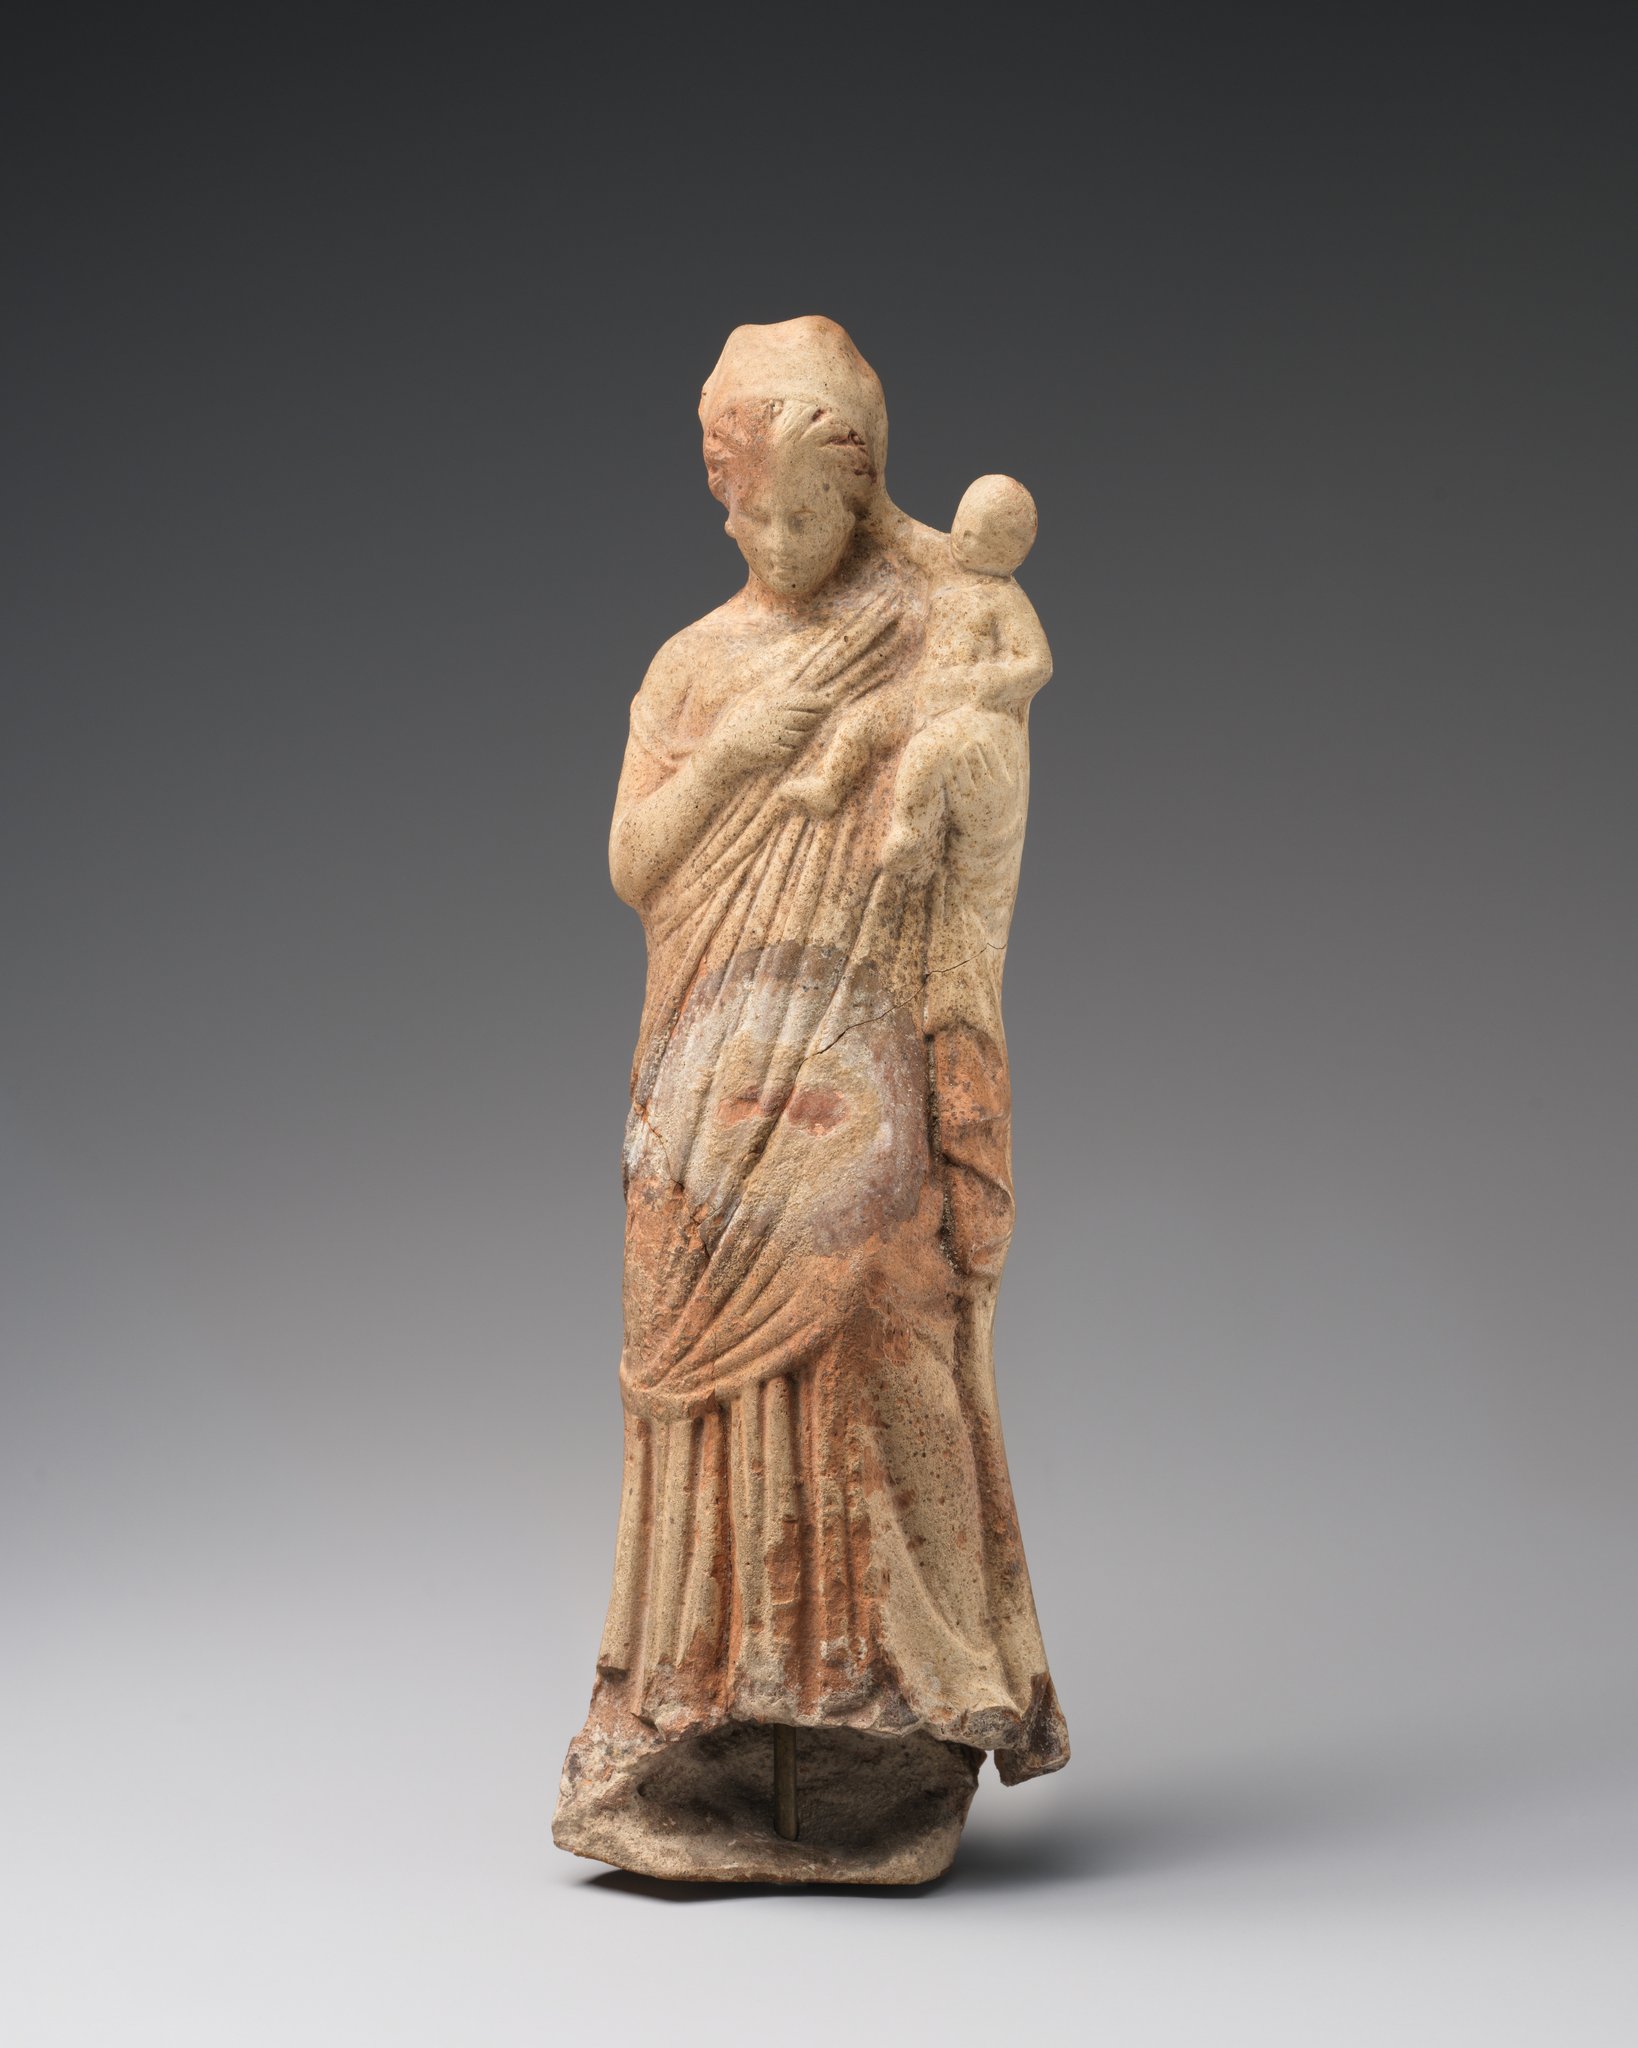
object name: statuette of a woman with infant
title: Terracotta statuette of a woman holding a baby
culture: greek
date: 200-1 BCE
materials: terracotta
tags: infants,women